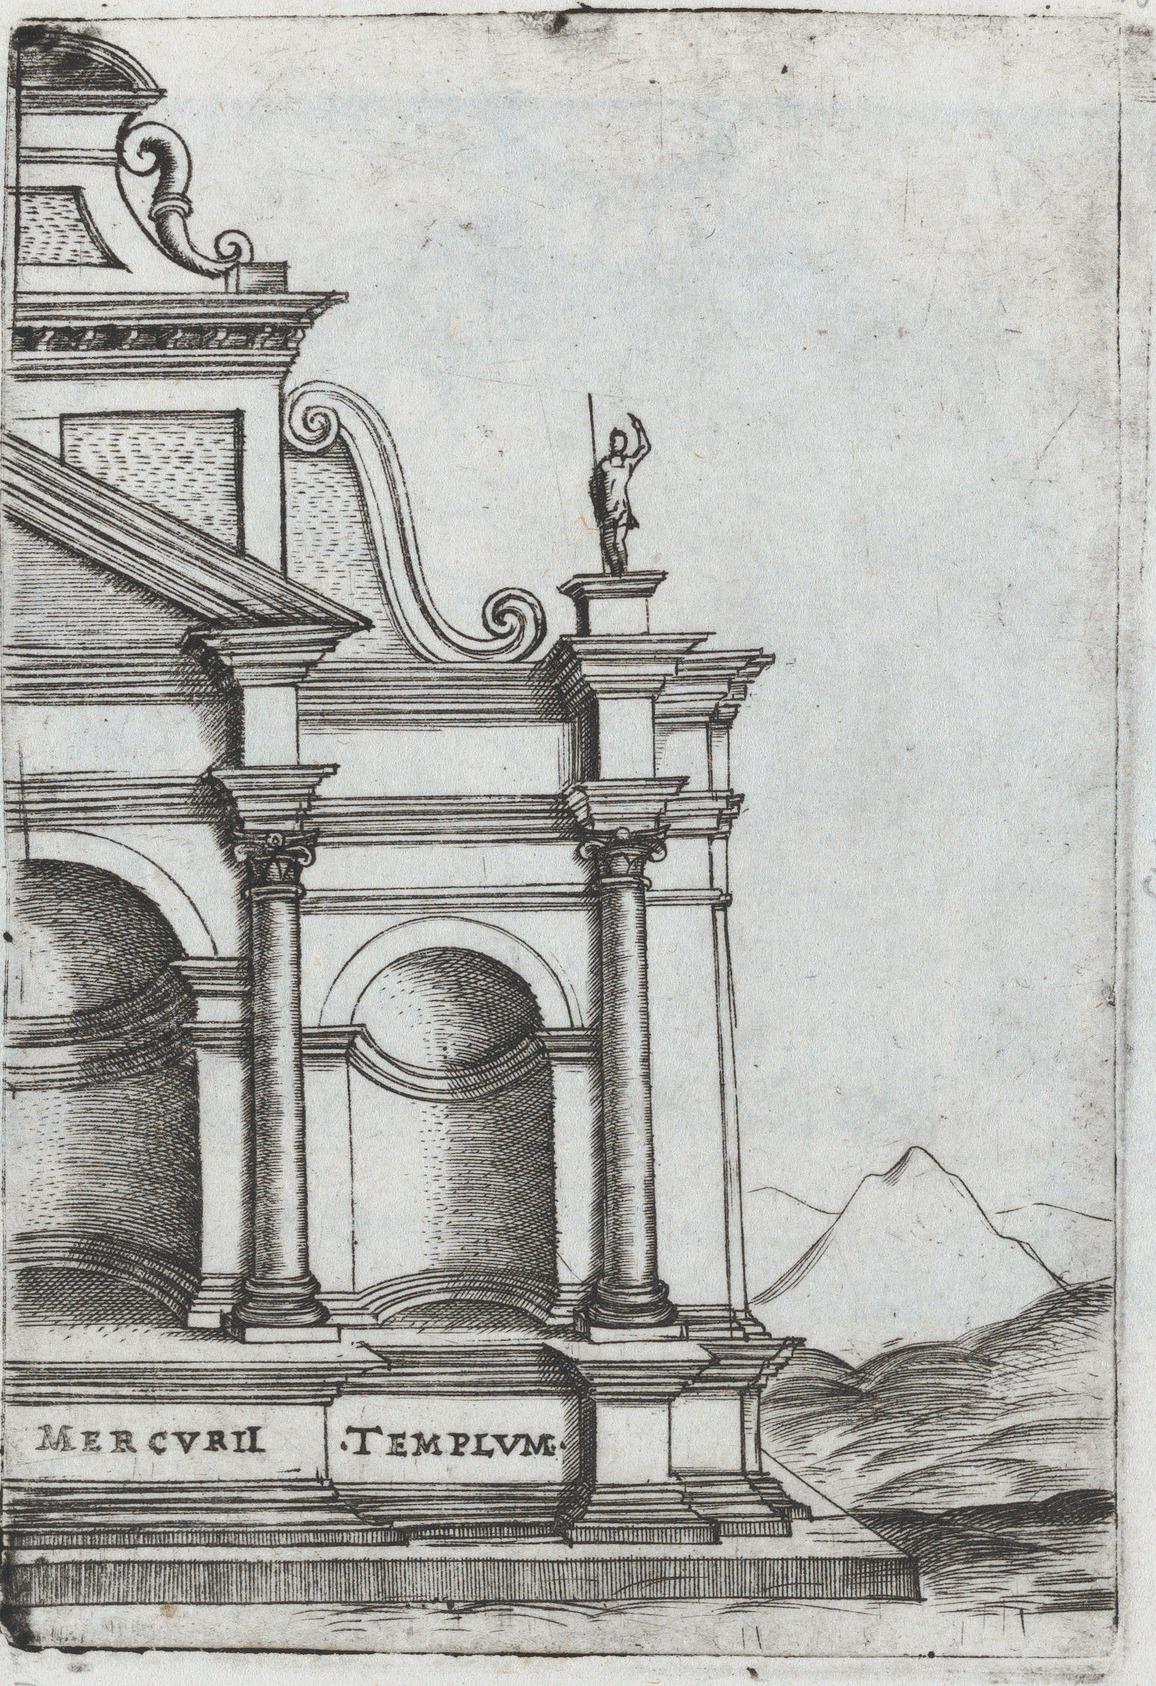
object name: album print ornament architecture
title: Palatium Caesaris Parisiis, from a Series of Prints depicting (reconstructed) Buildings from Roman Antiquity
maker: monogrammist g.a. with the caltrop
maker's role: artist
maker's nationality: italian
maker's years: 1535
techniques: engraving, printing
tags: architecture,arches,columns